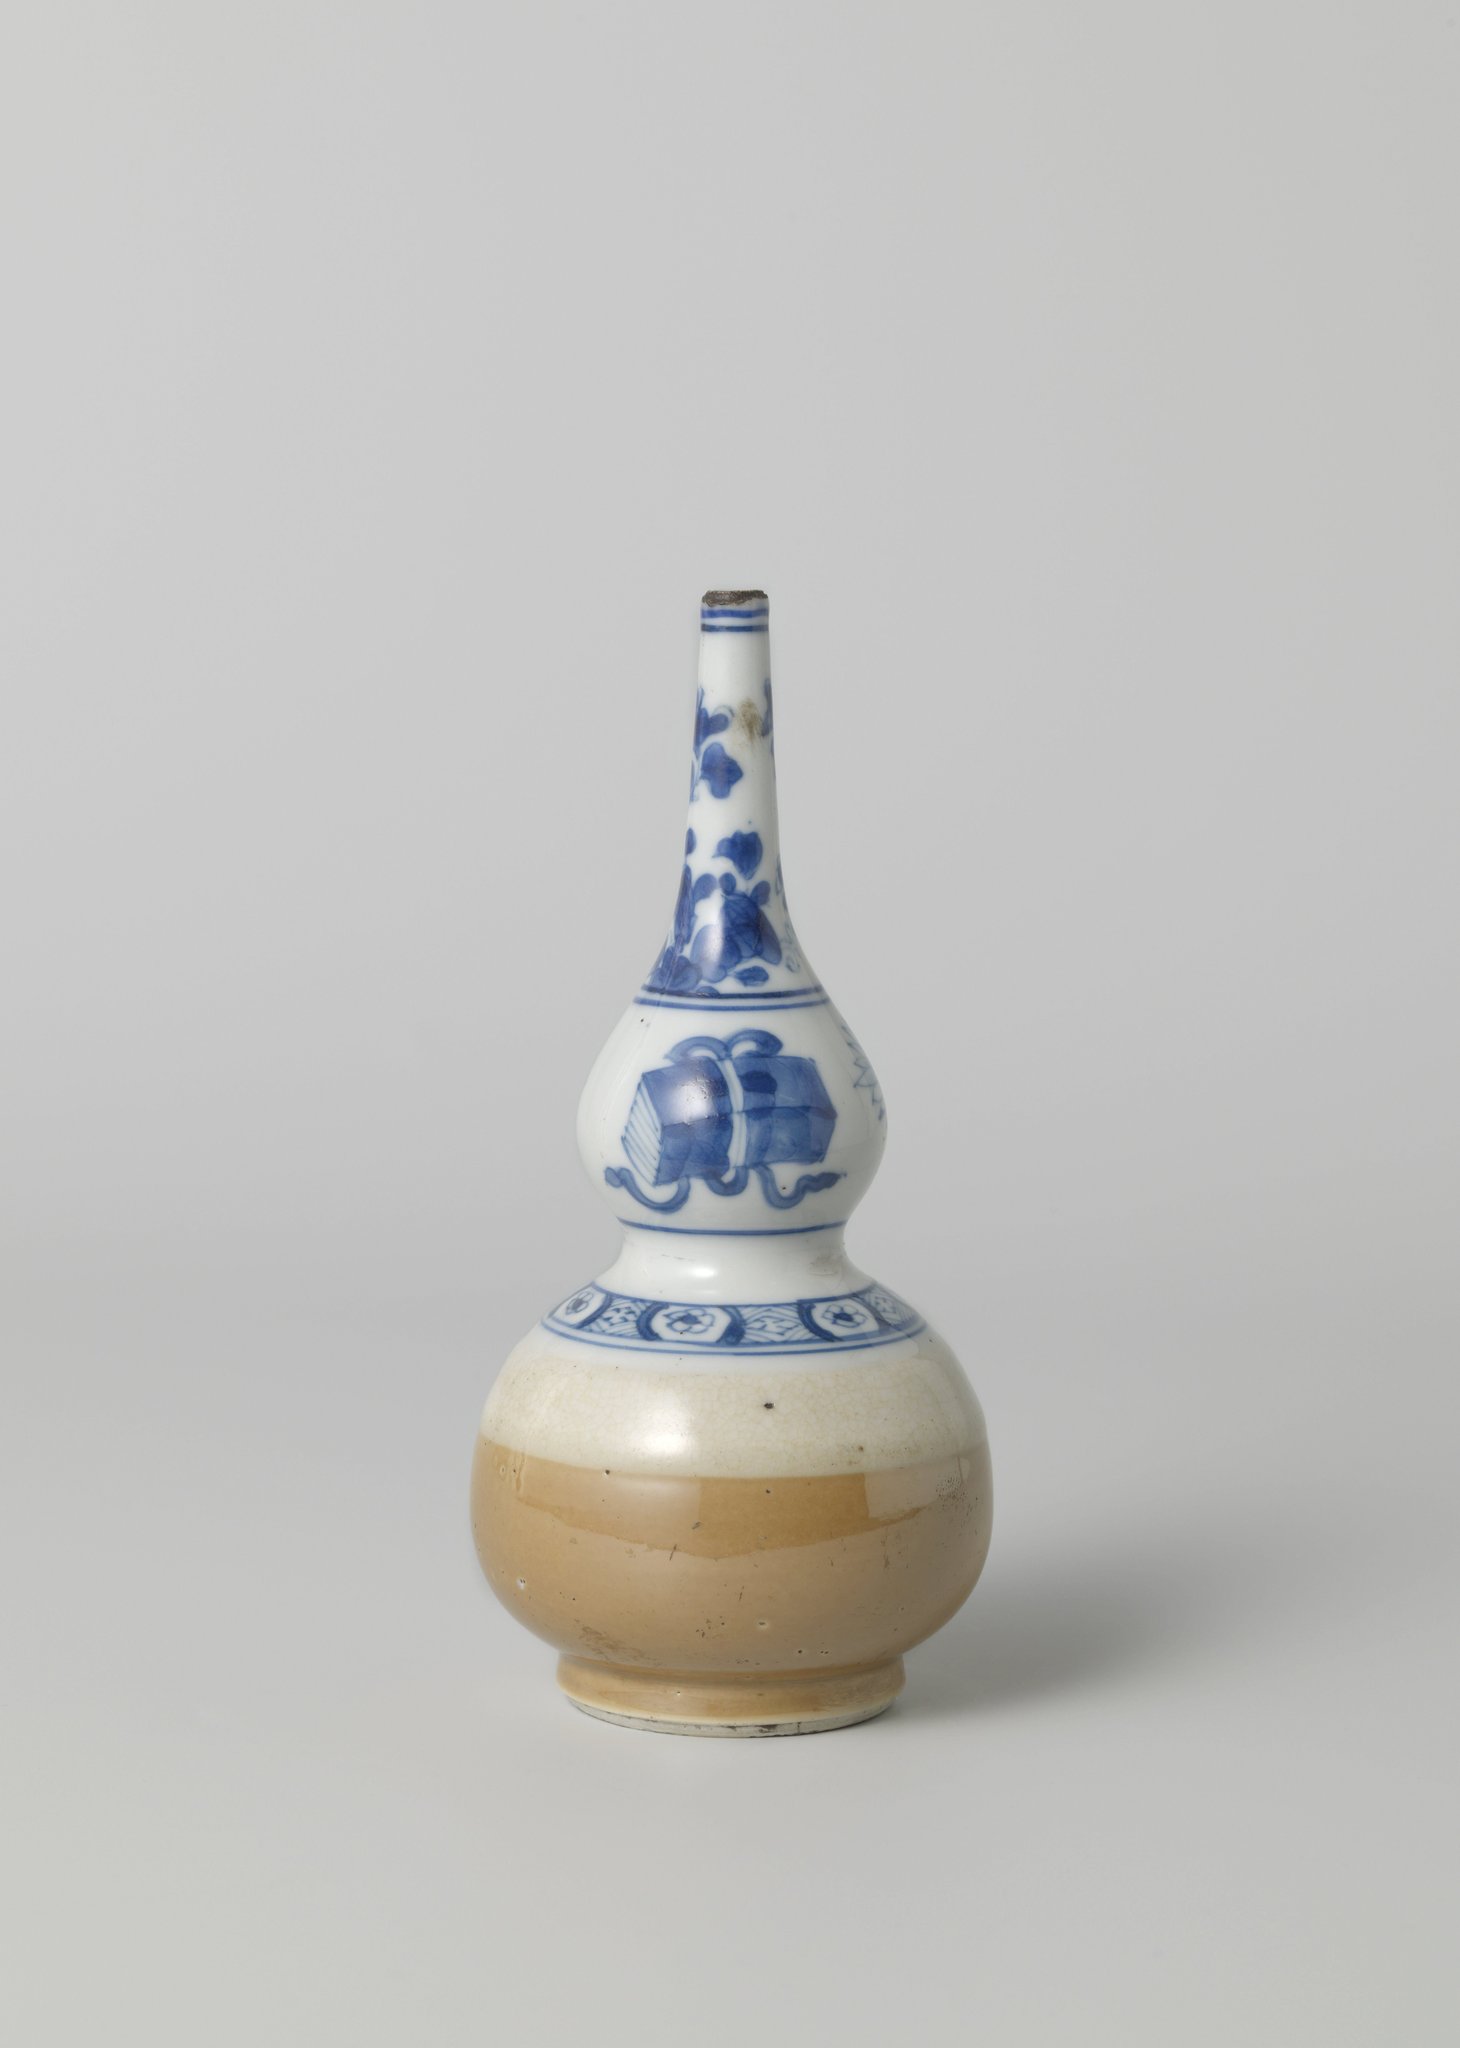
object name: sprinkler flask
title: Rosewater sprinkler or bottle vase with light brown and antiquities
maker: Anonymous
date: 1700-1724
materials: cobalt, glaze, paint, porcelain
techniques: firing, turning, vitrification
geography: china